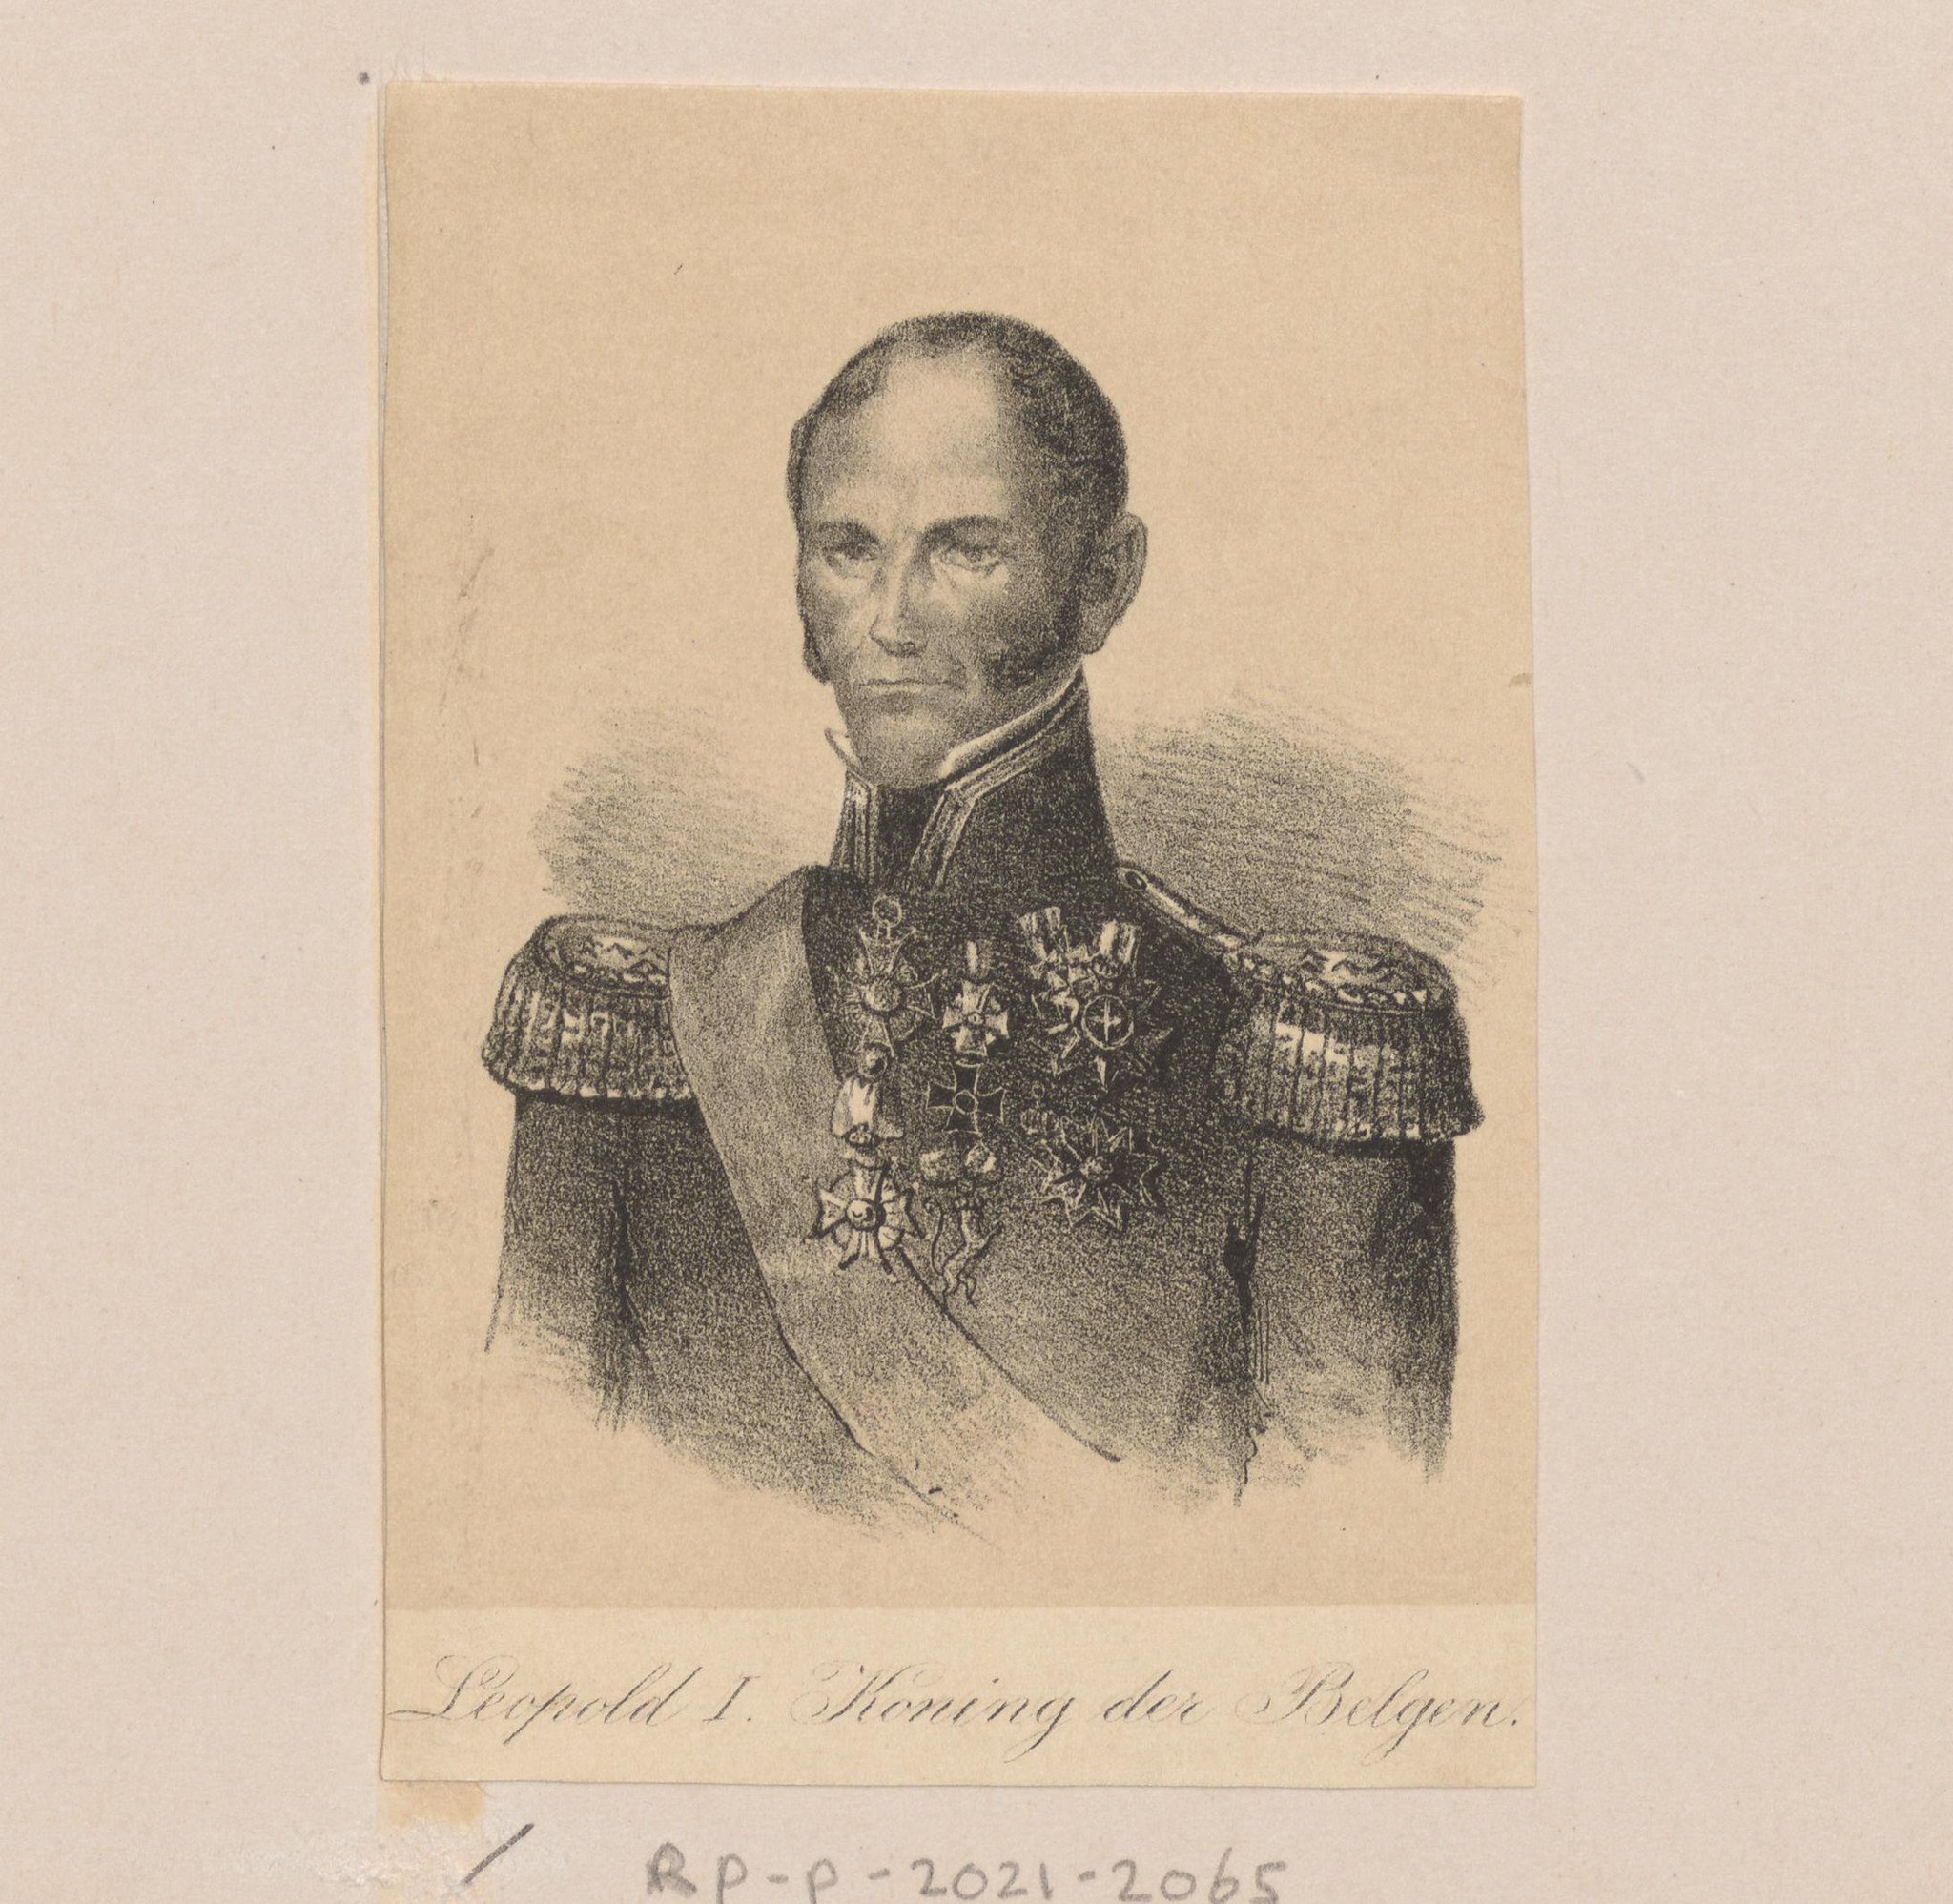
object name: print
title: Portret van Leopold I van België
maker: Anonymous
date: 1850-1865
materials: paper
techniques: tone lithography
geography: low countries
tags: laeken, leopold i (koning der belgen), knighthood order, historical persons, (military) uniforms, king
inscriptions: number: ‘658’